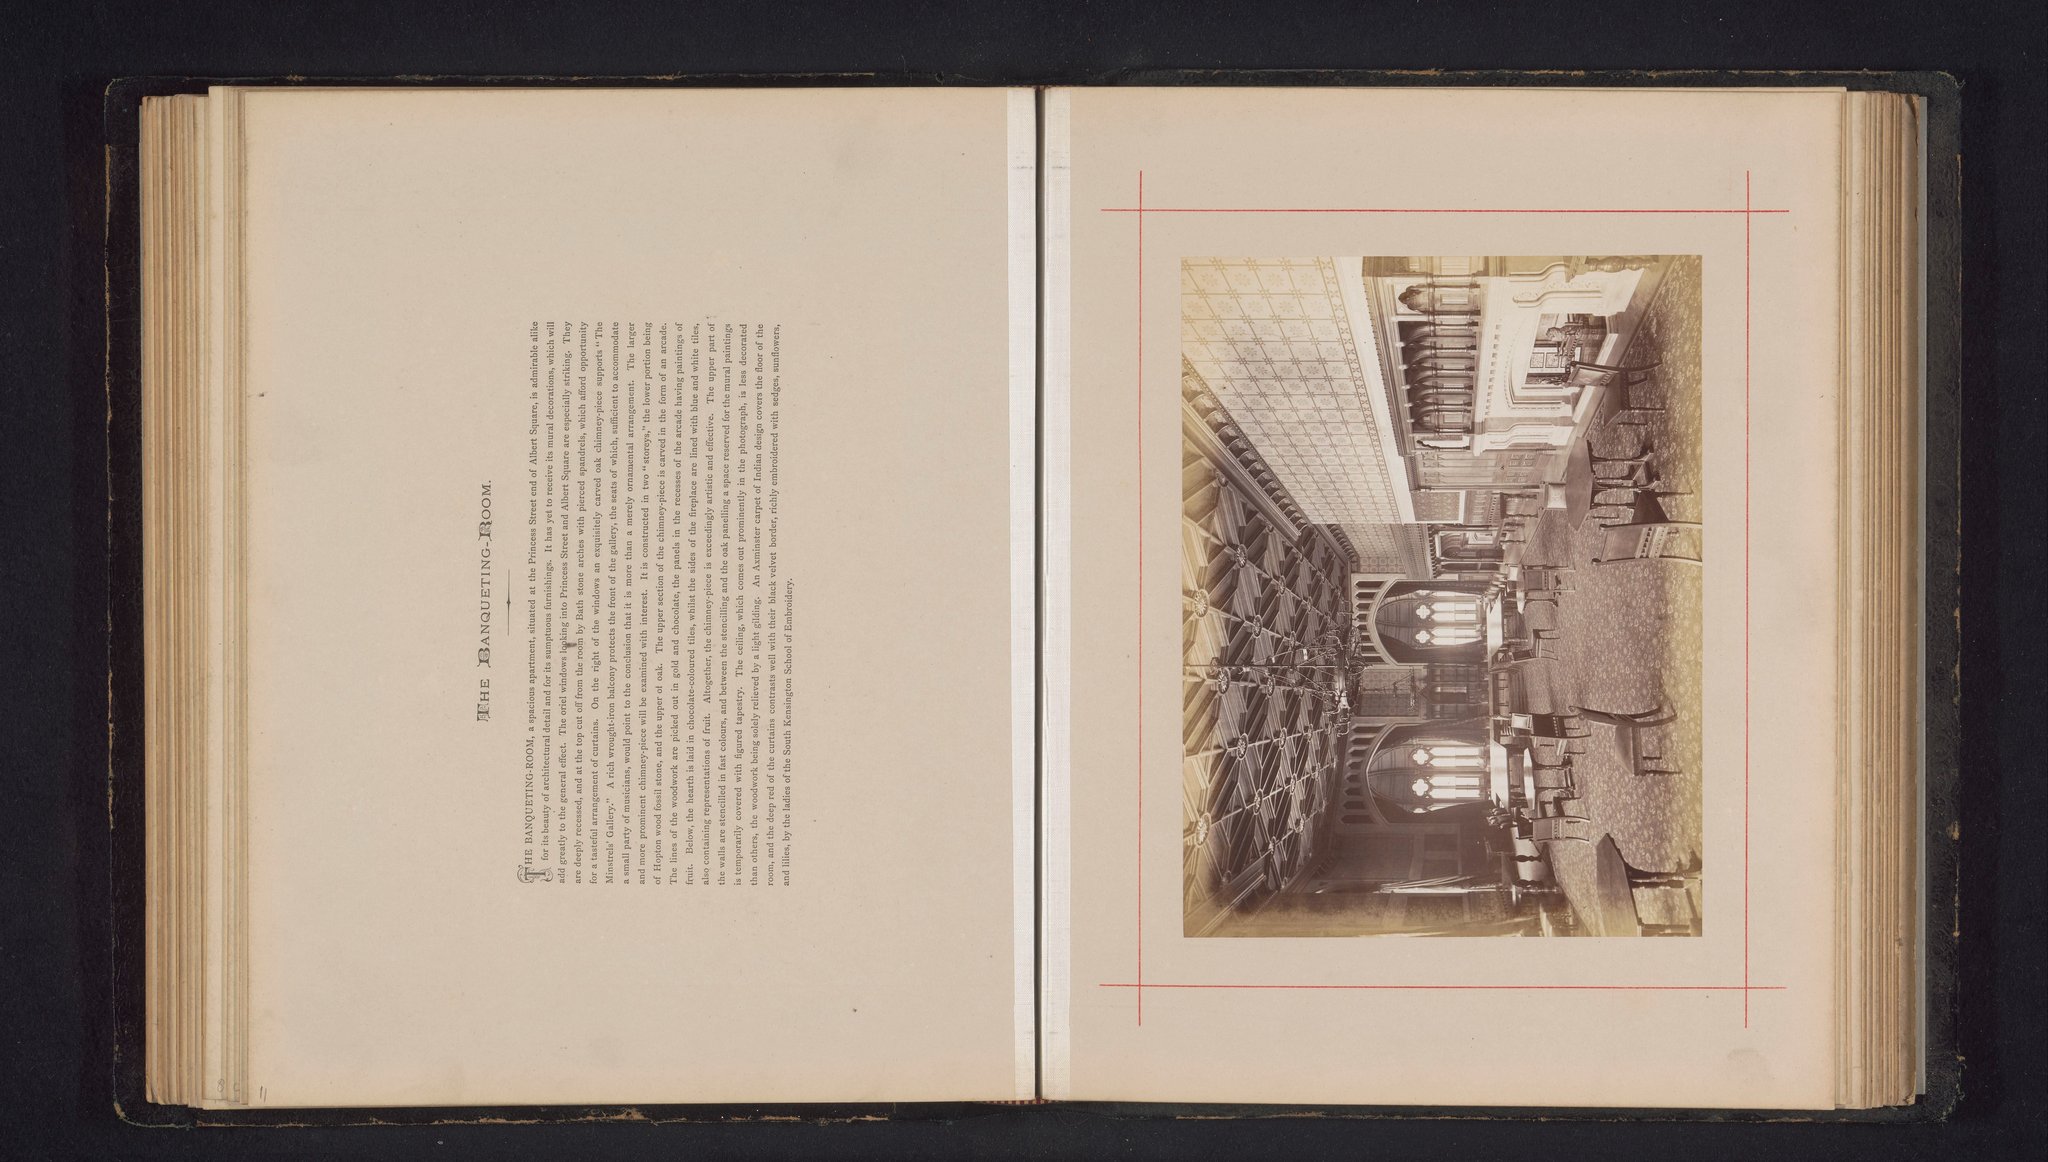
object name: page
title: Banketzaal in het Stadhuis van Manchester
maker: j. mcleod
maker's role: fotograaf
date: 1877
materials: photographic support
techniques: albumen print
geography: manchester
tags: townhall, celebration meal, feast, banquet, interior ~ representation of a building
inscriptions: title: ‘The Banqueting-Room’